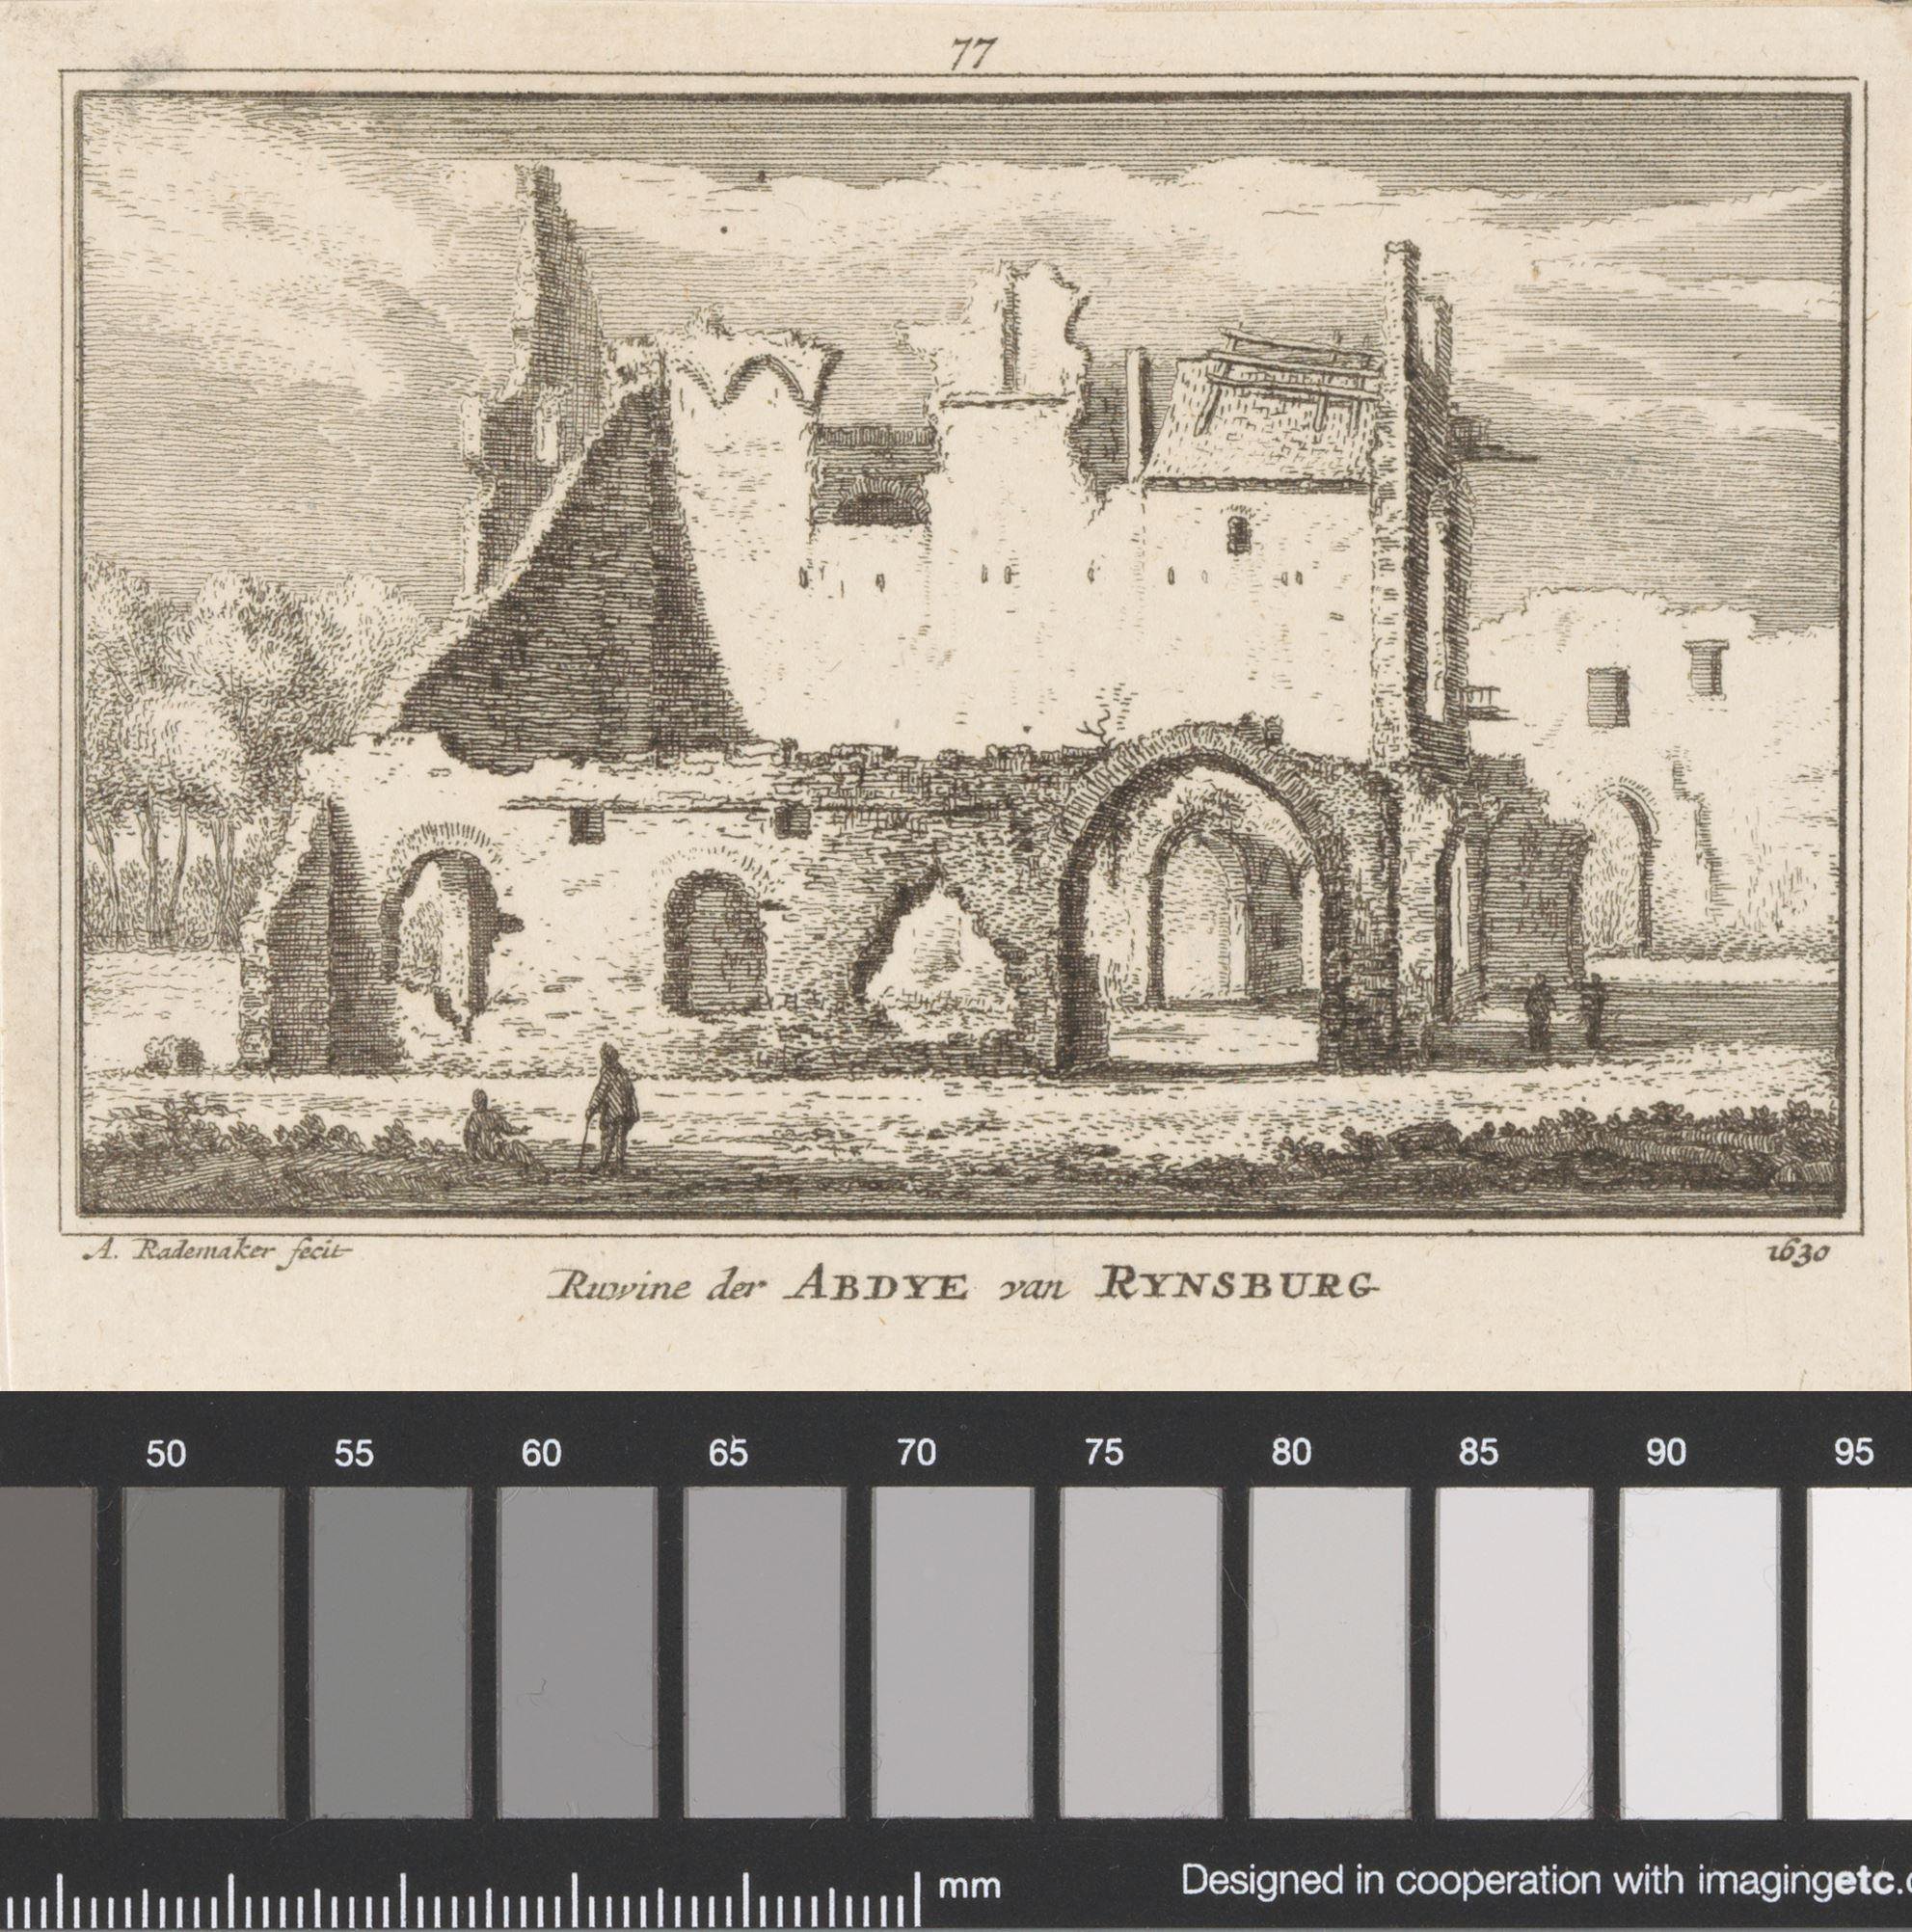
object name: print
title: Ruwine der abdye van Rynsburg 1630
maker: abraham rademaker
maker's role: draughtsman, print maker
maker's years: 1676-1735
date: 1725-1803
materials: paper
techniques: engraving, etching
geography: amsterdam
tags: ruin of church, monastery, etc.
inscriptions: collector's mark: Lugt 2228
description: Prent ook gebruikt in: Rademaker, Abraham. Kabinet van Nederlandsche outheden en gezichten: vervat in 300 konstplaaten (…). 2 delen. Amsterdam: Willem Barents, 1725, dl. 1, ill. 77. Na 1725 is deze prent nog in verschillende heruitgaven verschenen, uitgegeven in 1727-1733, 1770-1771 en 1792-1803. Uit welke uitgave het huidige exemplaar precies komt is niet na te gaan.